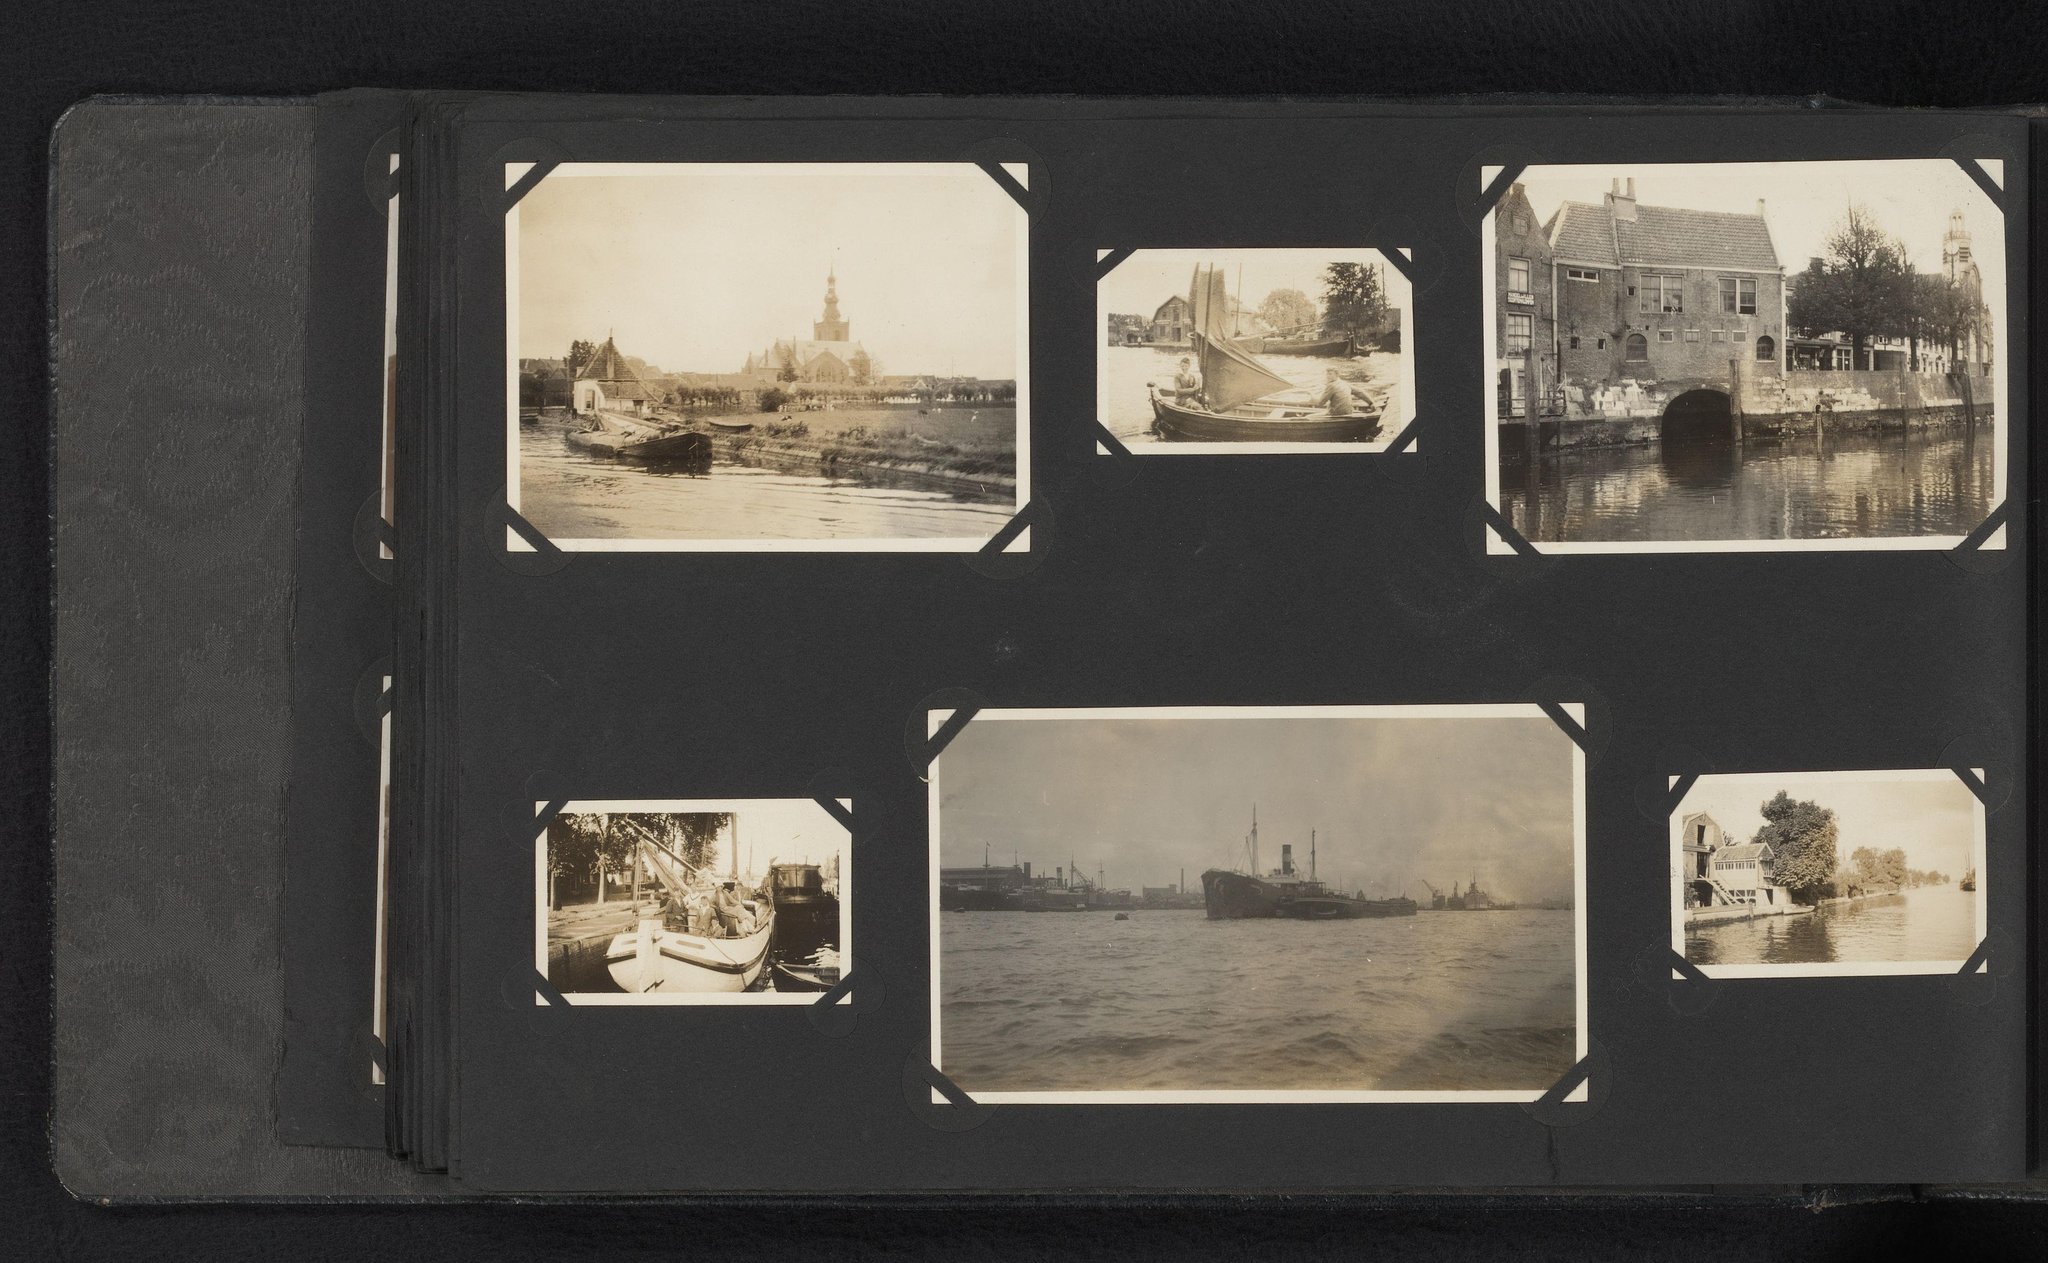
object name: photograph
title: Zes foto's van een boottocht met zeilboot De Snits en rivieren in Nederland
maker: hendrik herman van den berg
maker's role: amateurfotograaf, jurist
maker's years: 1875-1944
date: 1926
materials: paper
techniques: gelatin silver print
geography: netherlands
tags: harbour, sailing-ship, sailing-boat, river, netherlands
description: Deze foto's maken deel uit van een album.